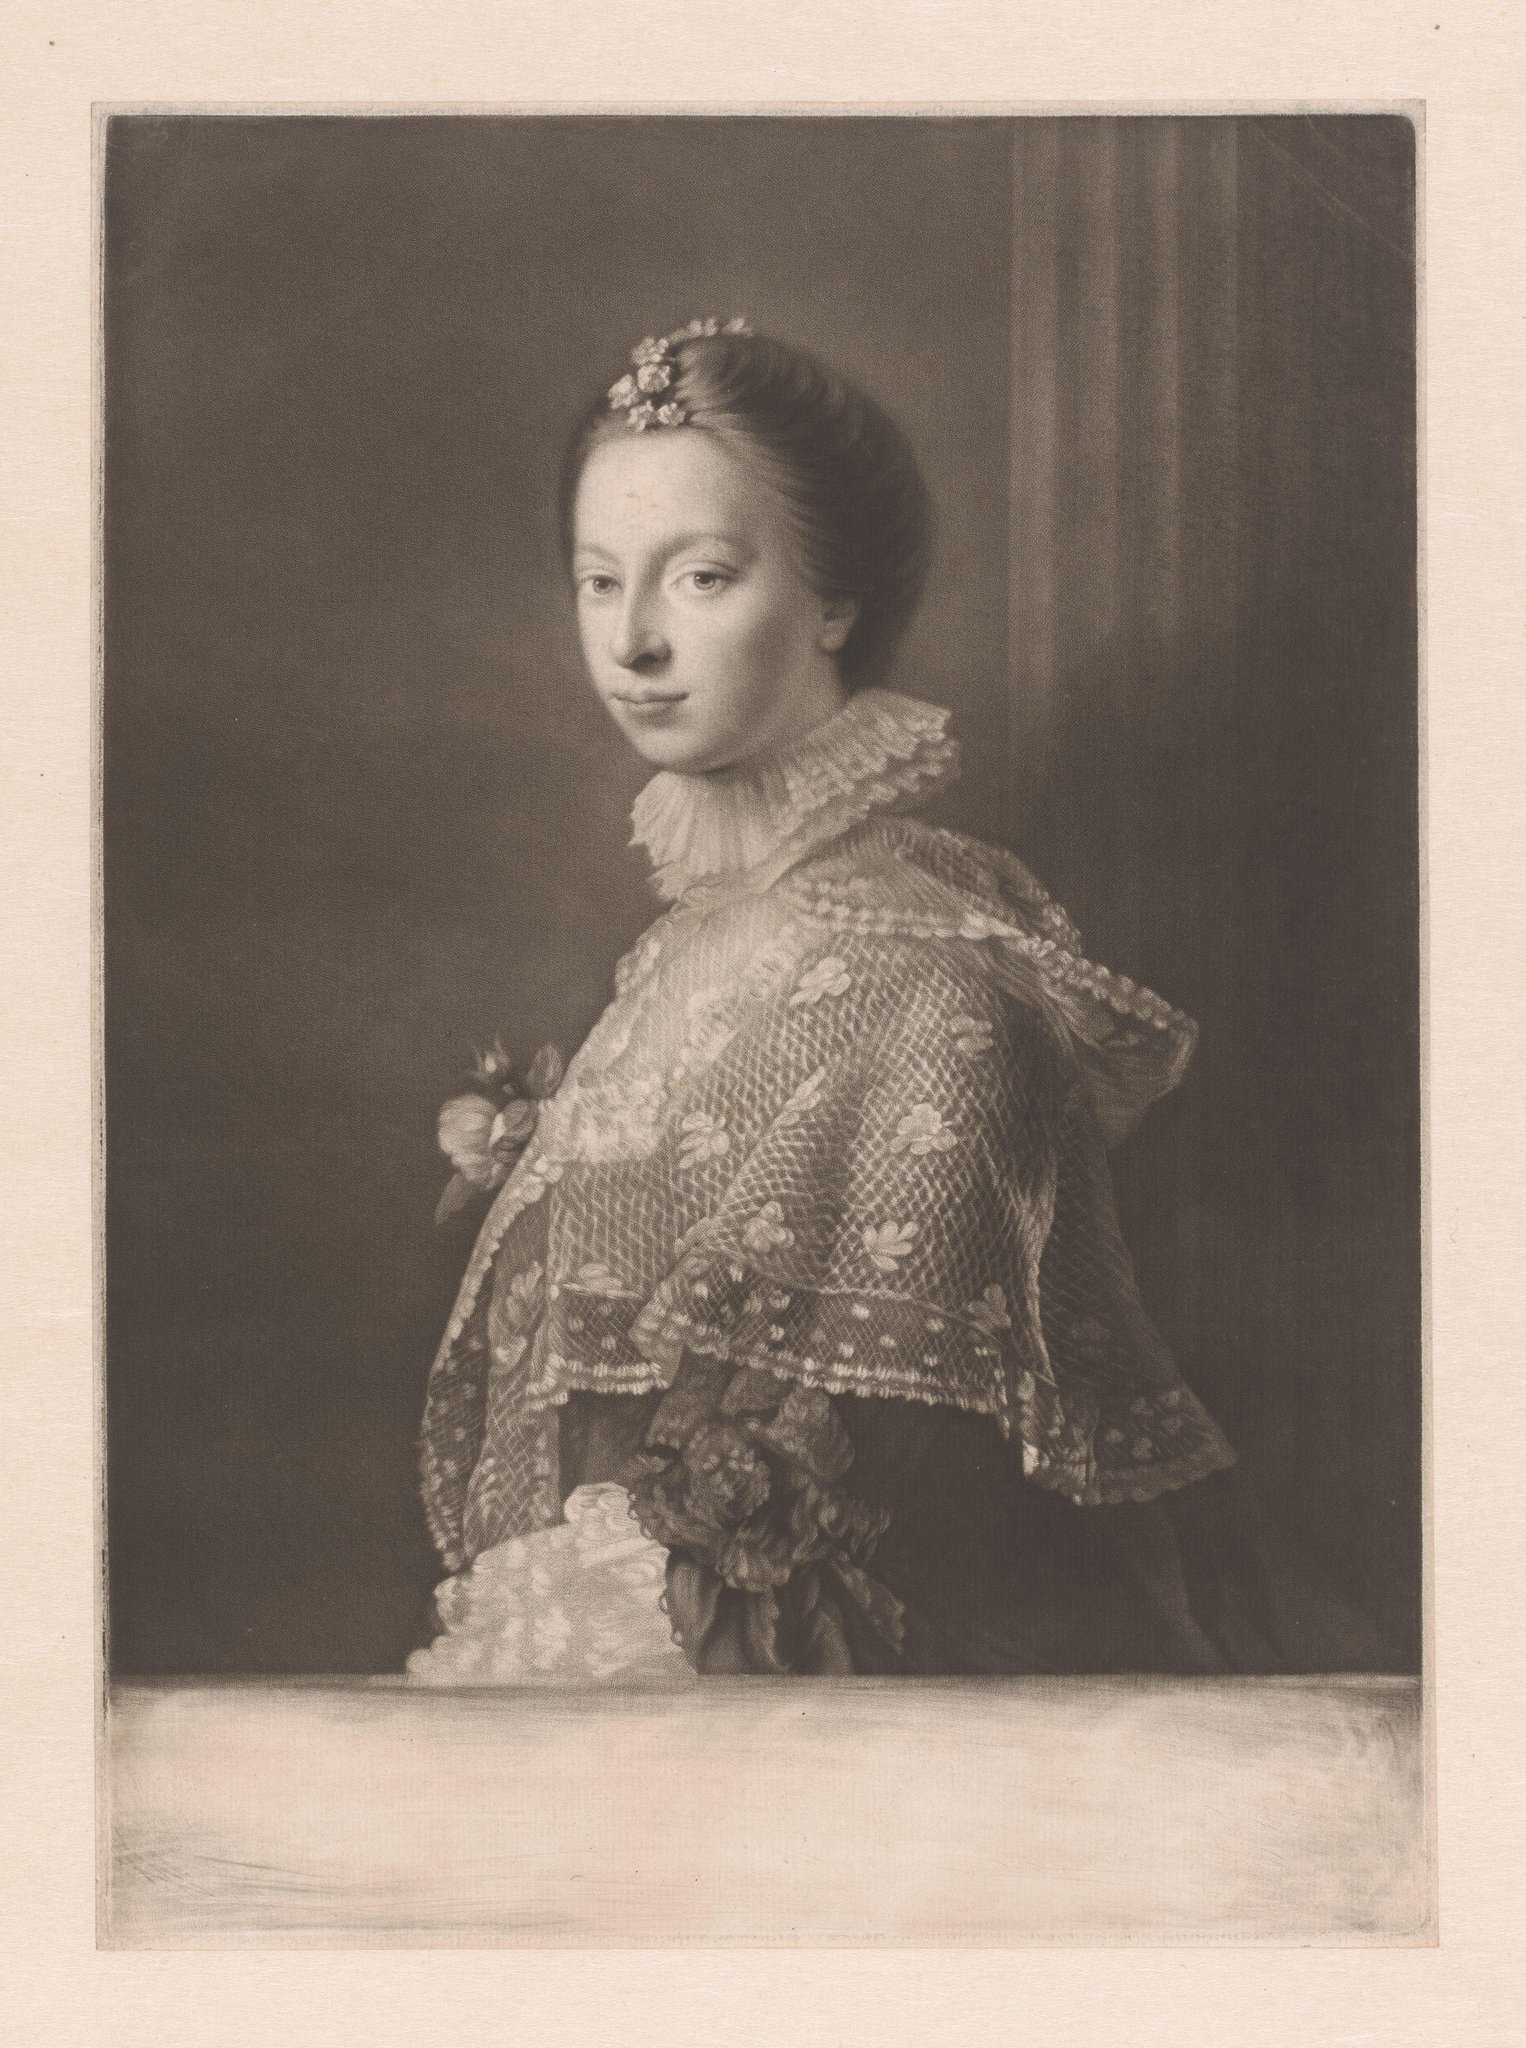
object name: print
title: Portret van Janet Erskine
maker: james watson (prentmaker)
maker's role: print maker, publisher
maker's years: 1740-1790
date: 1761-1790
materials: paper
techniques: mezzotint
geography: london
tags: historical persons - bb - woman, lace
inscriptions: collector's mark: Lugt 2760, collector's mark: Lugt 2228, collector's mark: Lugt 5881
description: Er waren verschillende Britse kunstenaars die geschilderde portretten in mezzotints reproduceerden. Deze techniek was in de tweede helft van de 18de eeuw in Engeland opgebloeid als het reproductiemiddel bij uitstek. Zij bood de mogelijkheid tot fijn geschakeerde overgangen, vooral bij de weergave van glimmende en zachtfluwelen stoffen. Op dit portret van Lady Erskine, gekleed in een kanten cape over een donkere japon, is het onderschrift nog niet aangebracht.